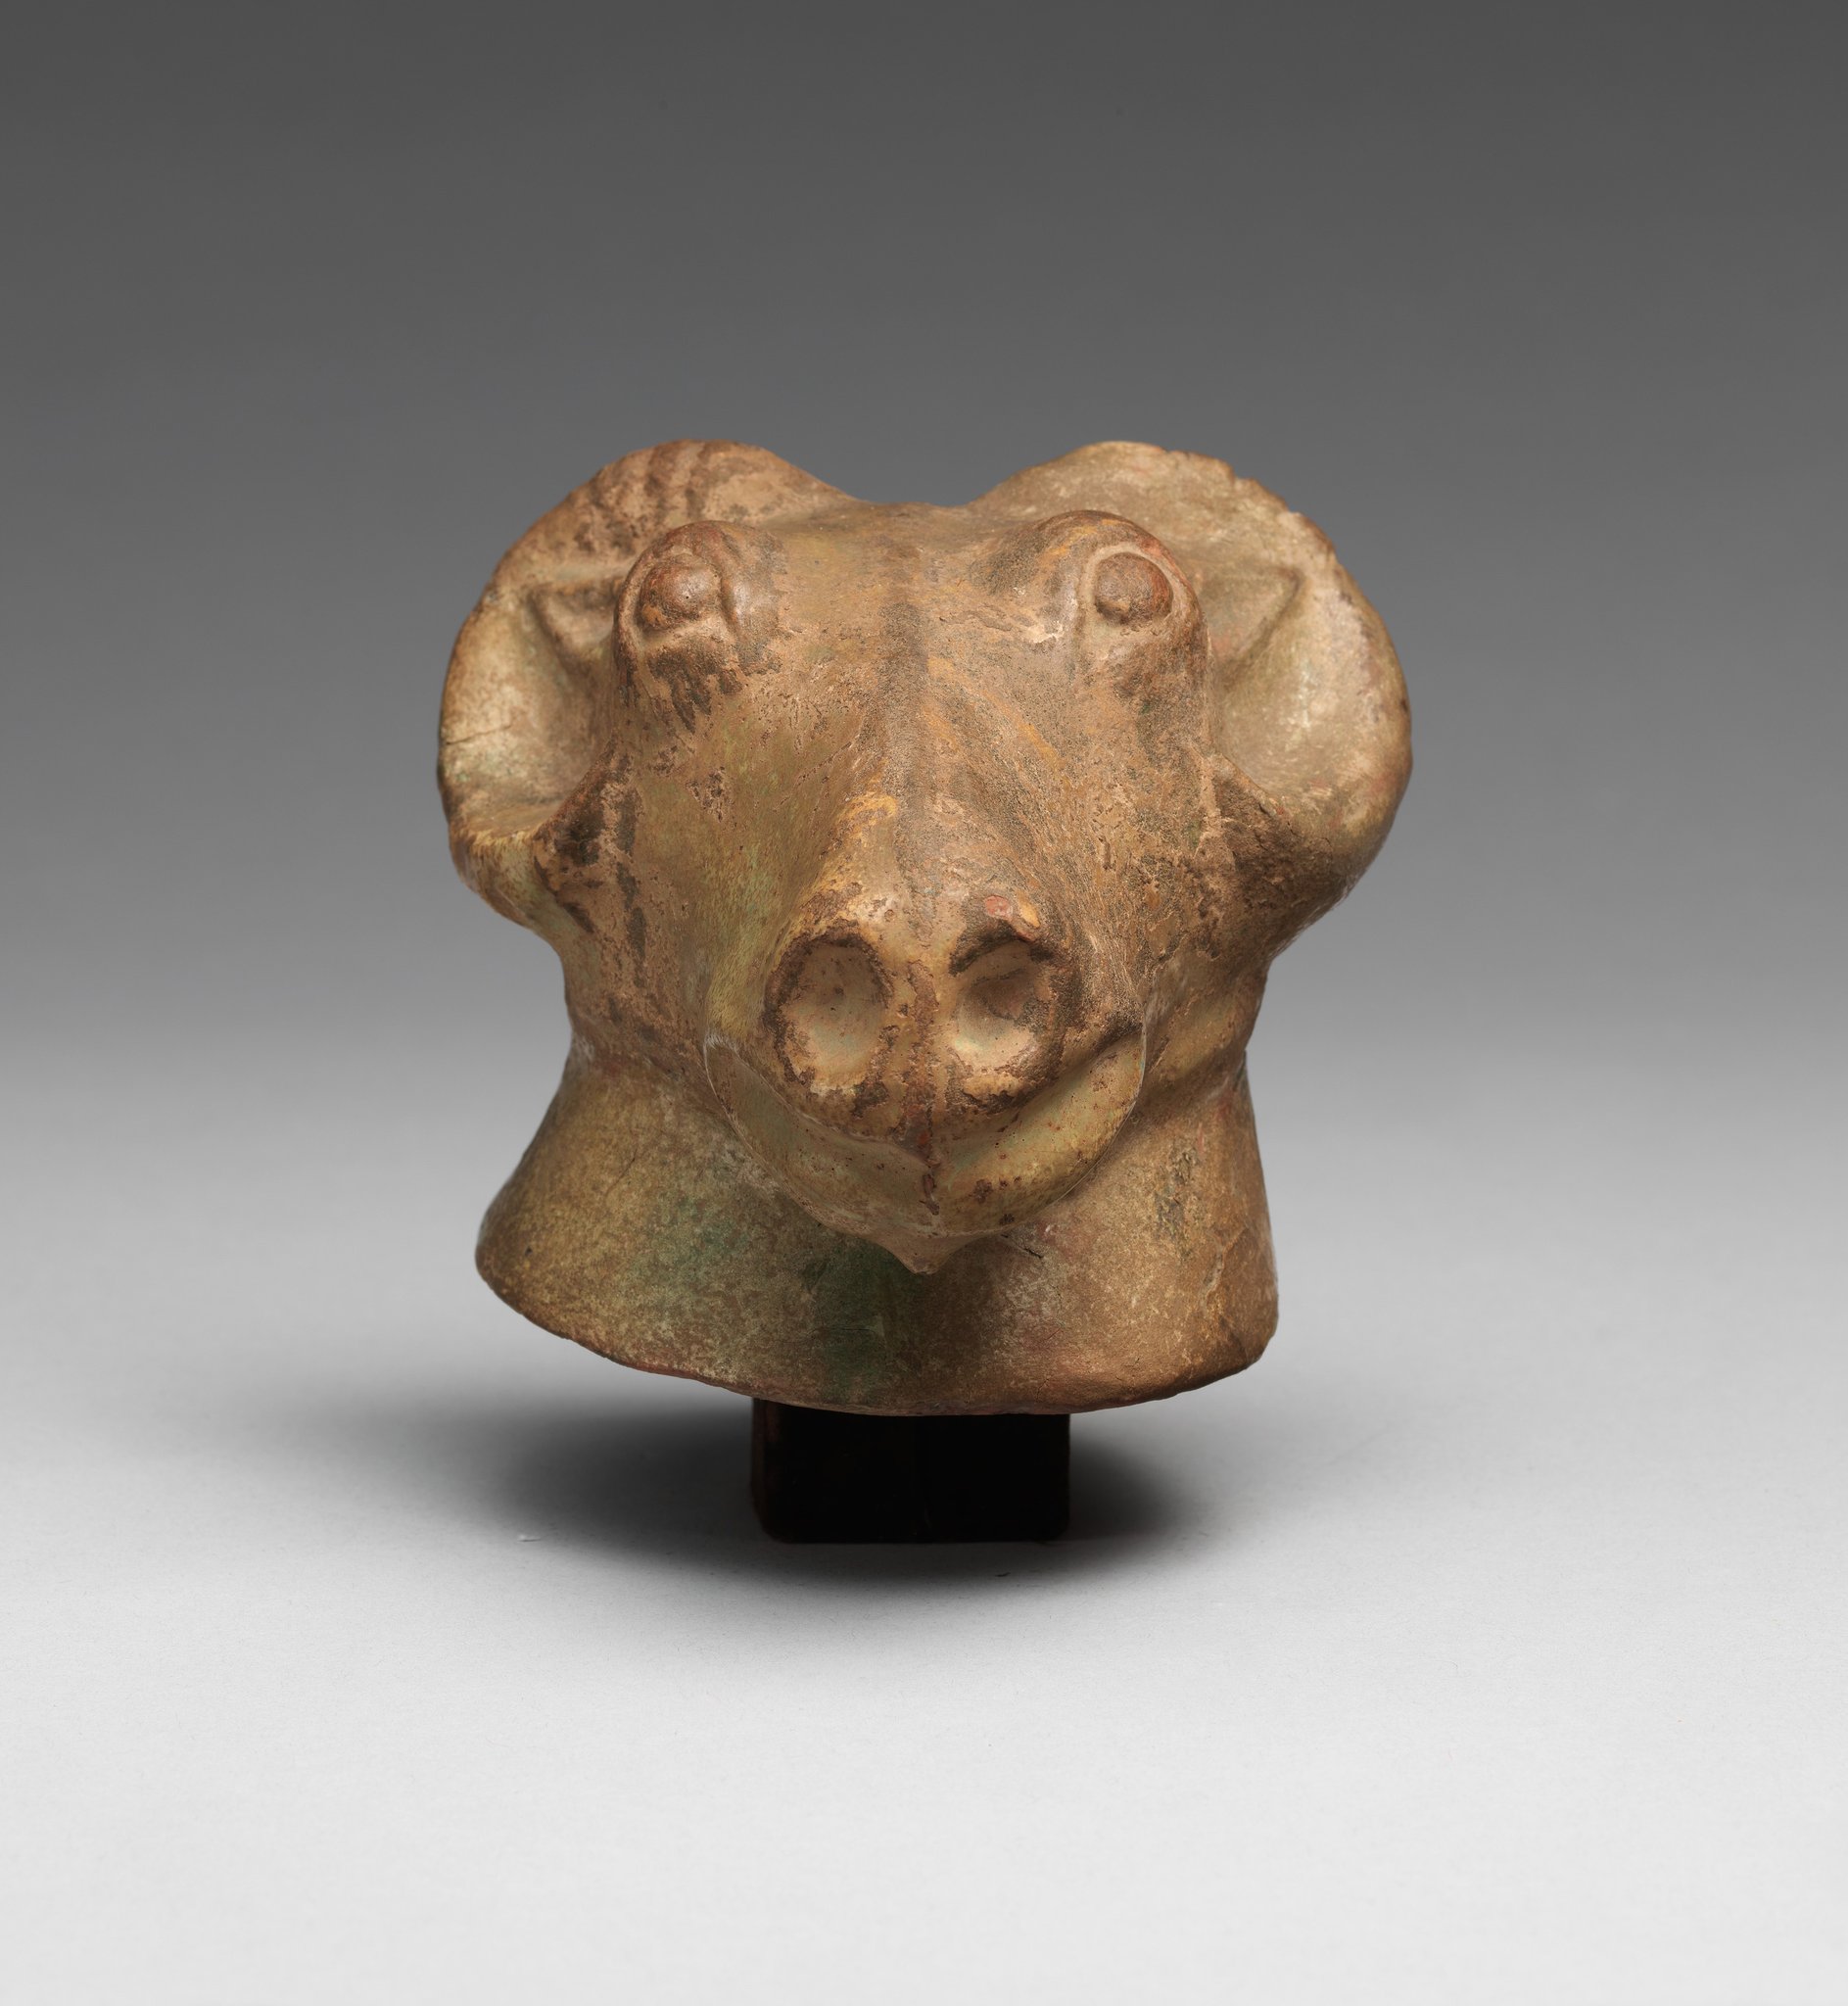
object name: head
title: Ram's Head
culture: chinese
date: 206 BCE-220 CE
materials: glaze, pottery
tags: rams